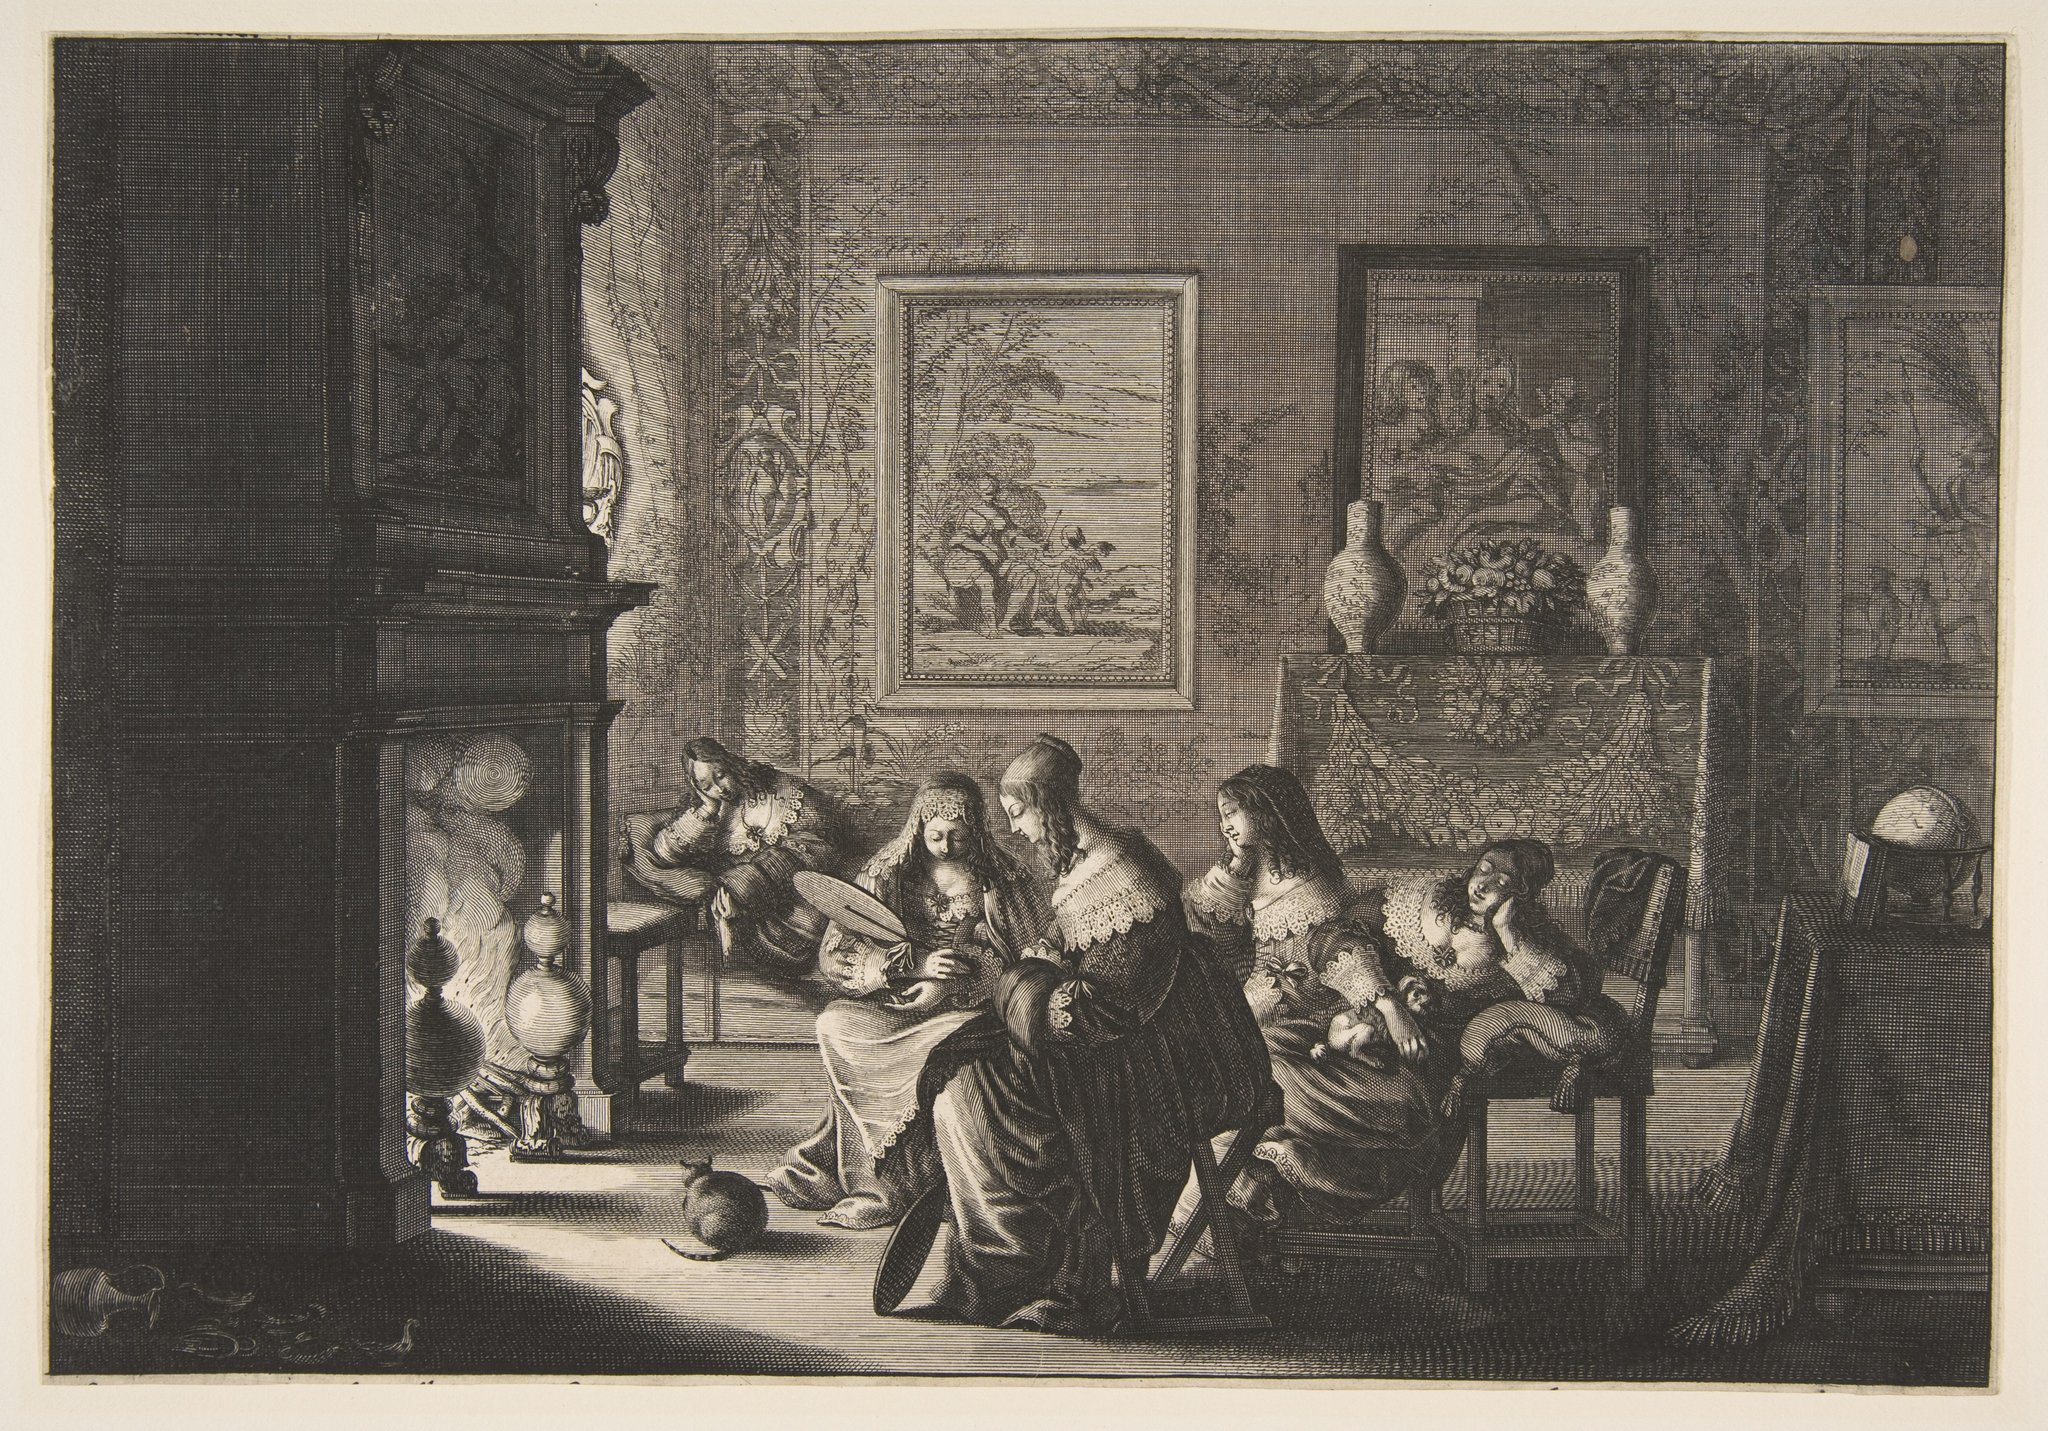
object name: print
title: Foolish Virgins Sleeping (Les Vierges folles sommolent en attendant l'arrivée de l'époux)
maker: abraham bosse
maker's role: artist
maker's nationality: french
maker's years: 1602-1676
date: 1635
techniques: etching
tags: sleeping,women